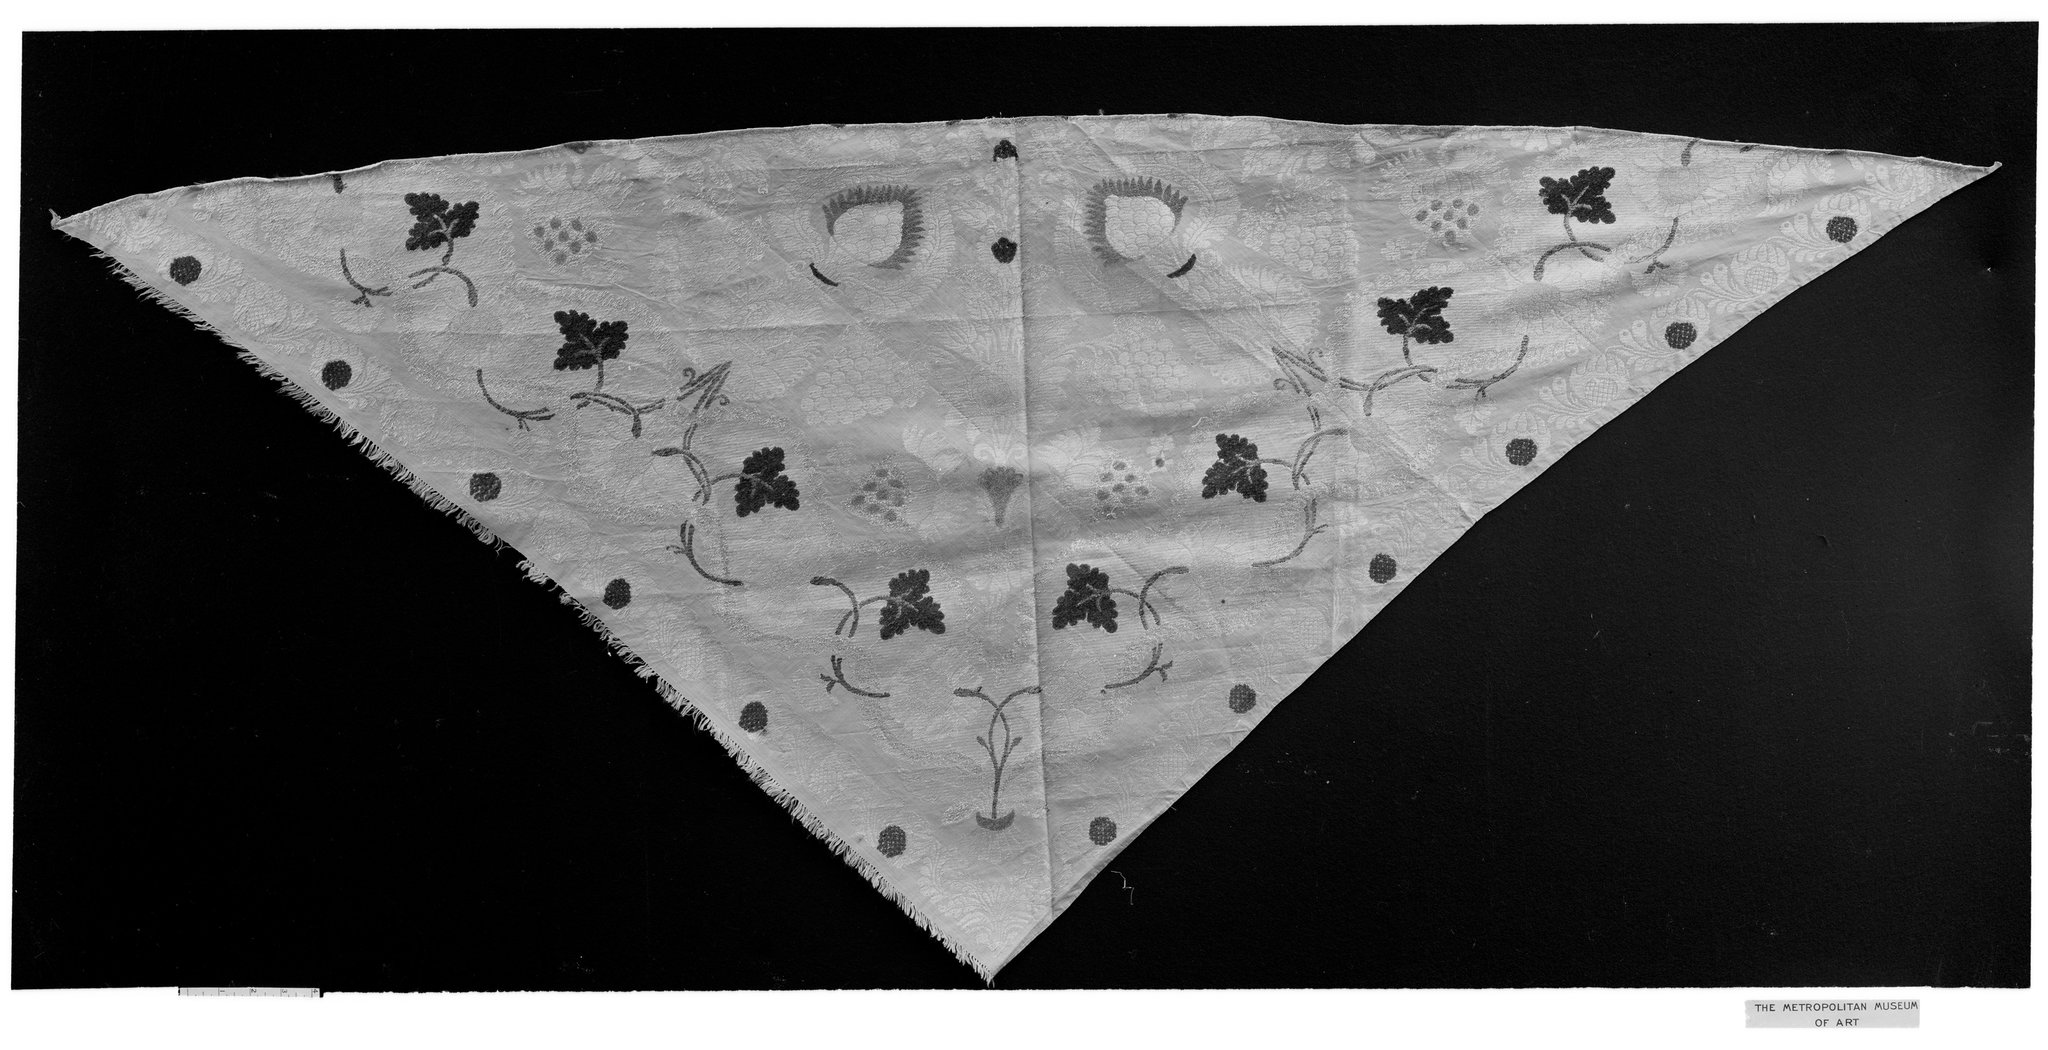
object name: piece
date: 1801-1900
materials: metal thread, silk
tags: leaves